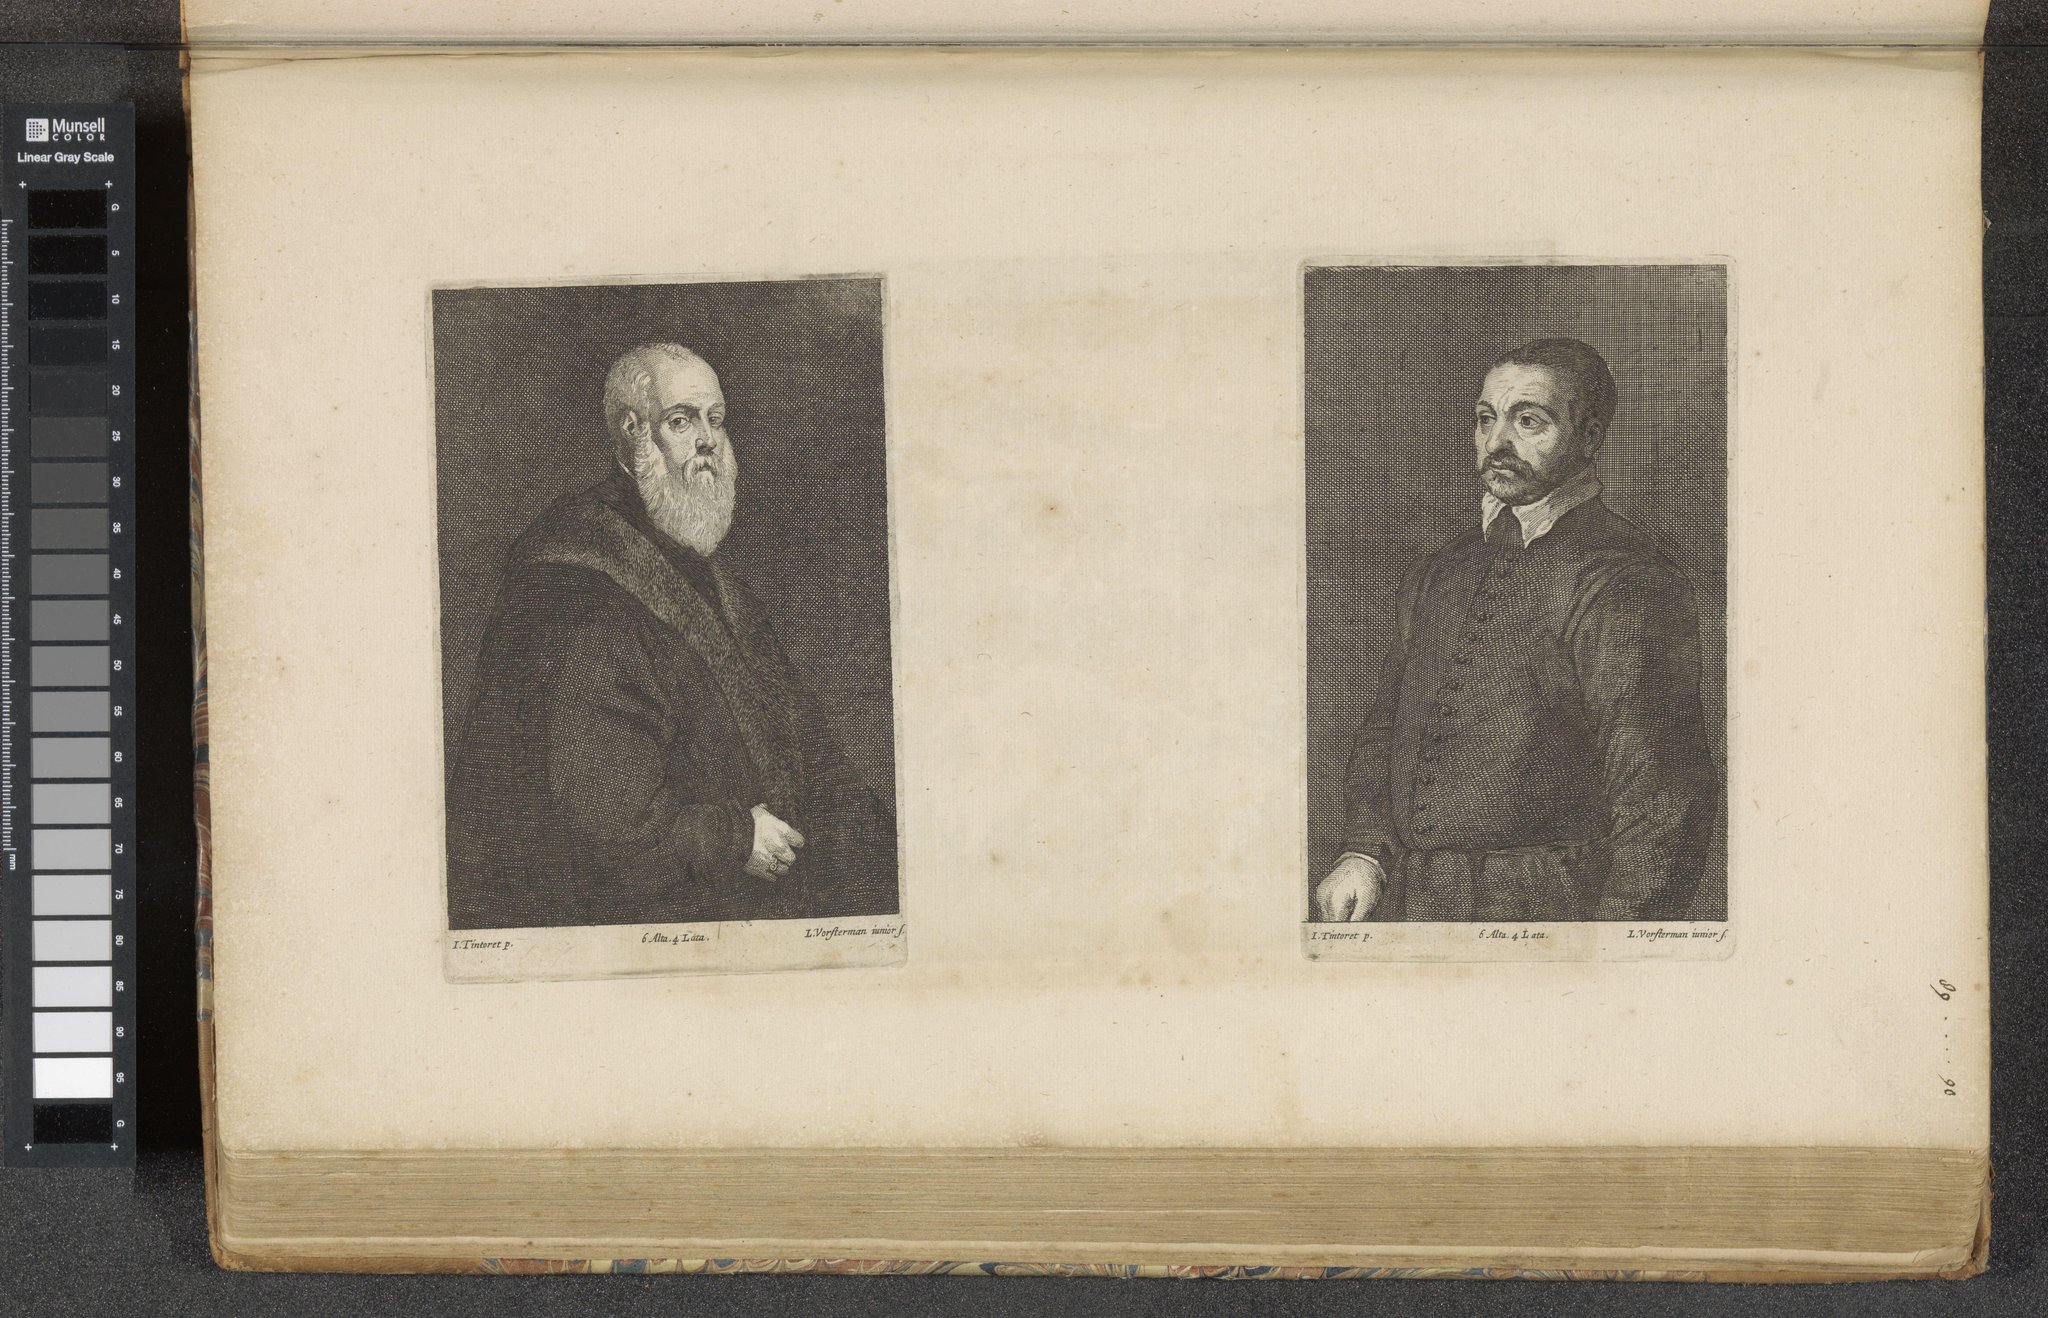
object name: print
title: Portret van een onbekende man met baard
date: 1660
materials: paper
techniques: etching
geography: italy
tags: adolescent, young woman, maiden, anonymous historical person portrayed alone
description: De prent is vervaardigd naar het schilderij van Tintoretto dat zich in de collectie van het Kunsthistorisches Museum te Wenen bevindt (inventarisnummer GG_25). De geschilderde kopie van Teniers bevindt zich in de collectie van The Courtauld Gallery te Londen. David Teniers heeft waarschijnlijk van alle schilderijen uit de collectie van Leopold Willem van Oostenrijk een olieverfstudie op doek of paneel vervaardigd (zgn. pasticcio), die als voorbeeld voor de prentmakers diende. Het is niet altijd duidelijk of de pasticci door hem zijn gemaakt of door zijn atelier. Niet alle pasticci zijn overgeleverd.